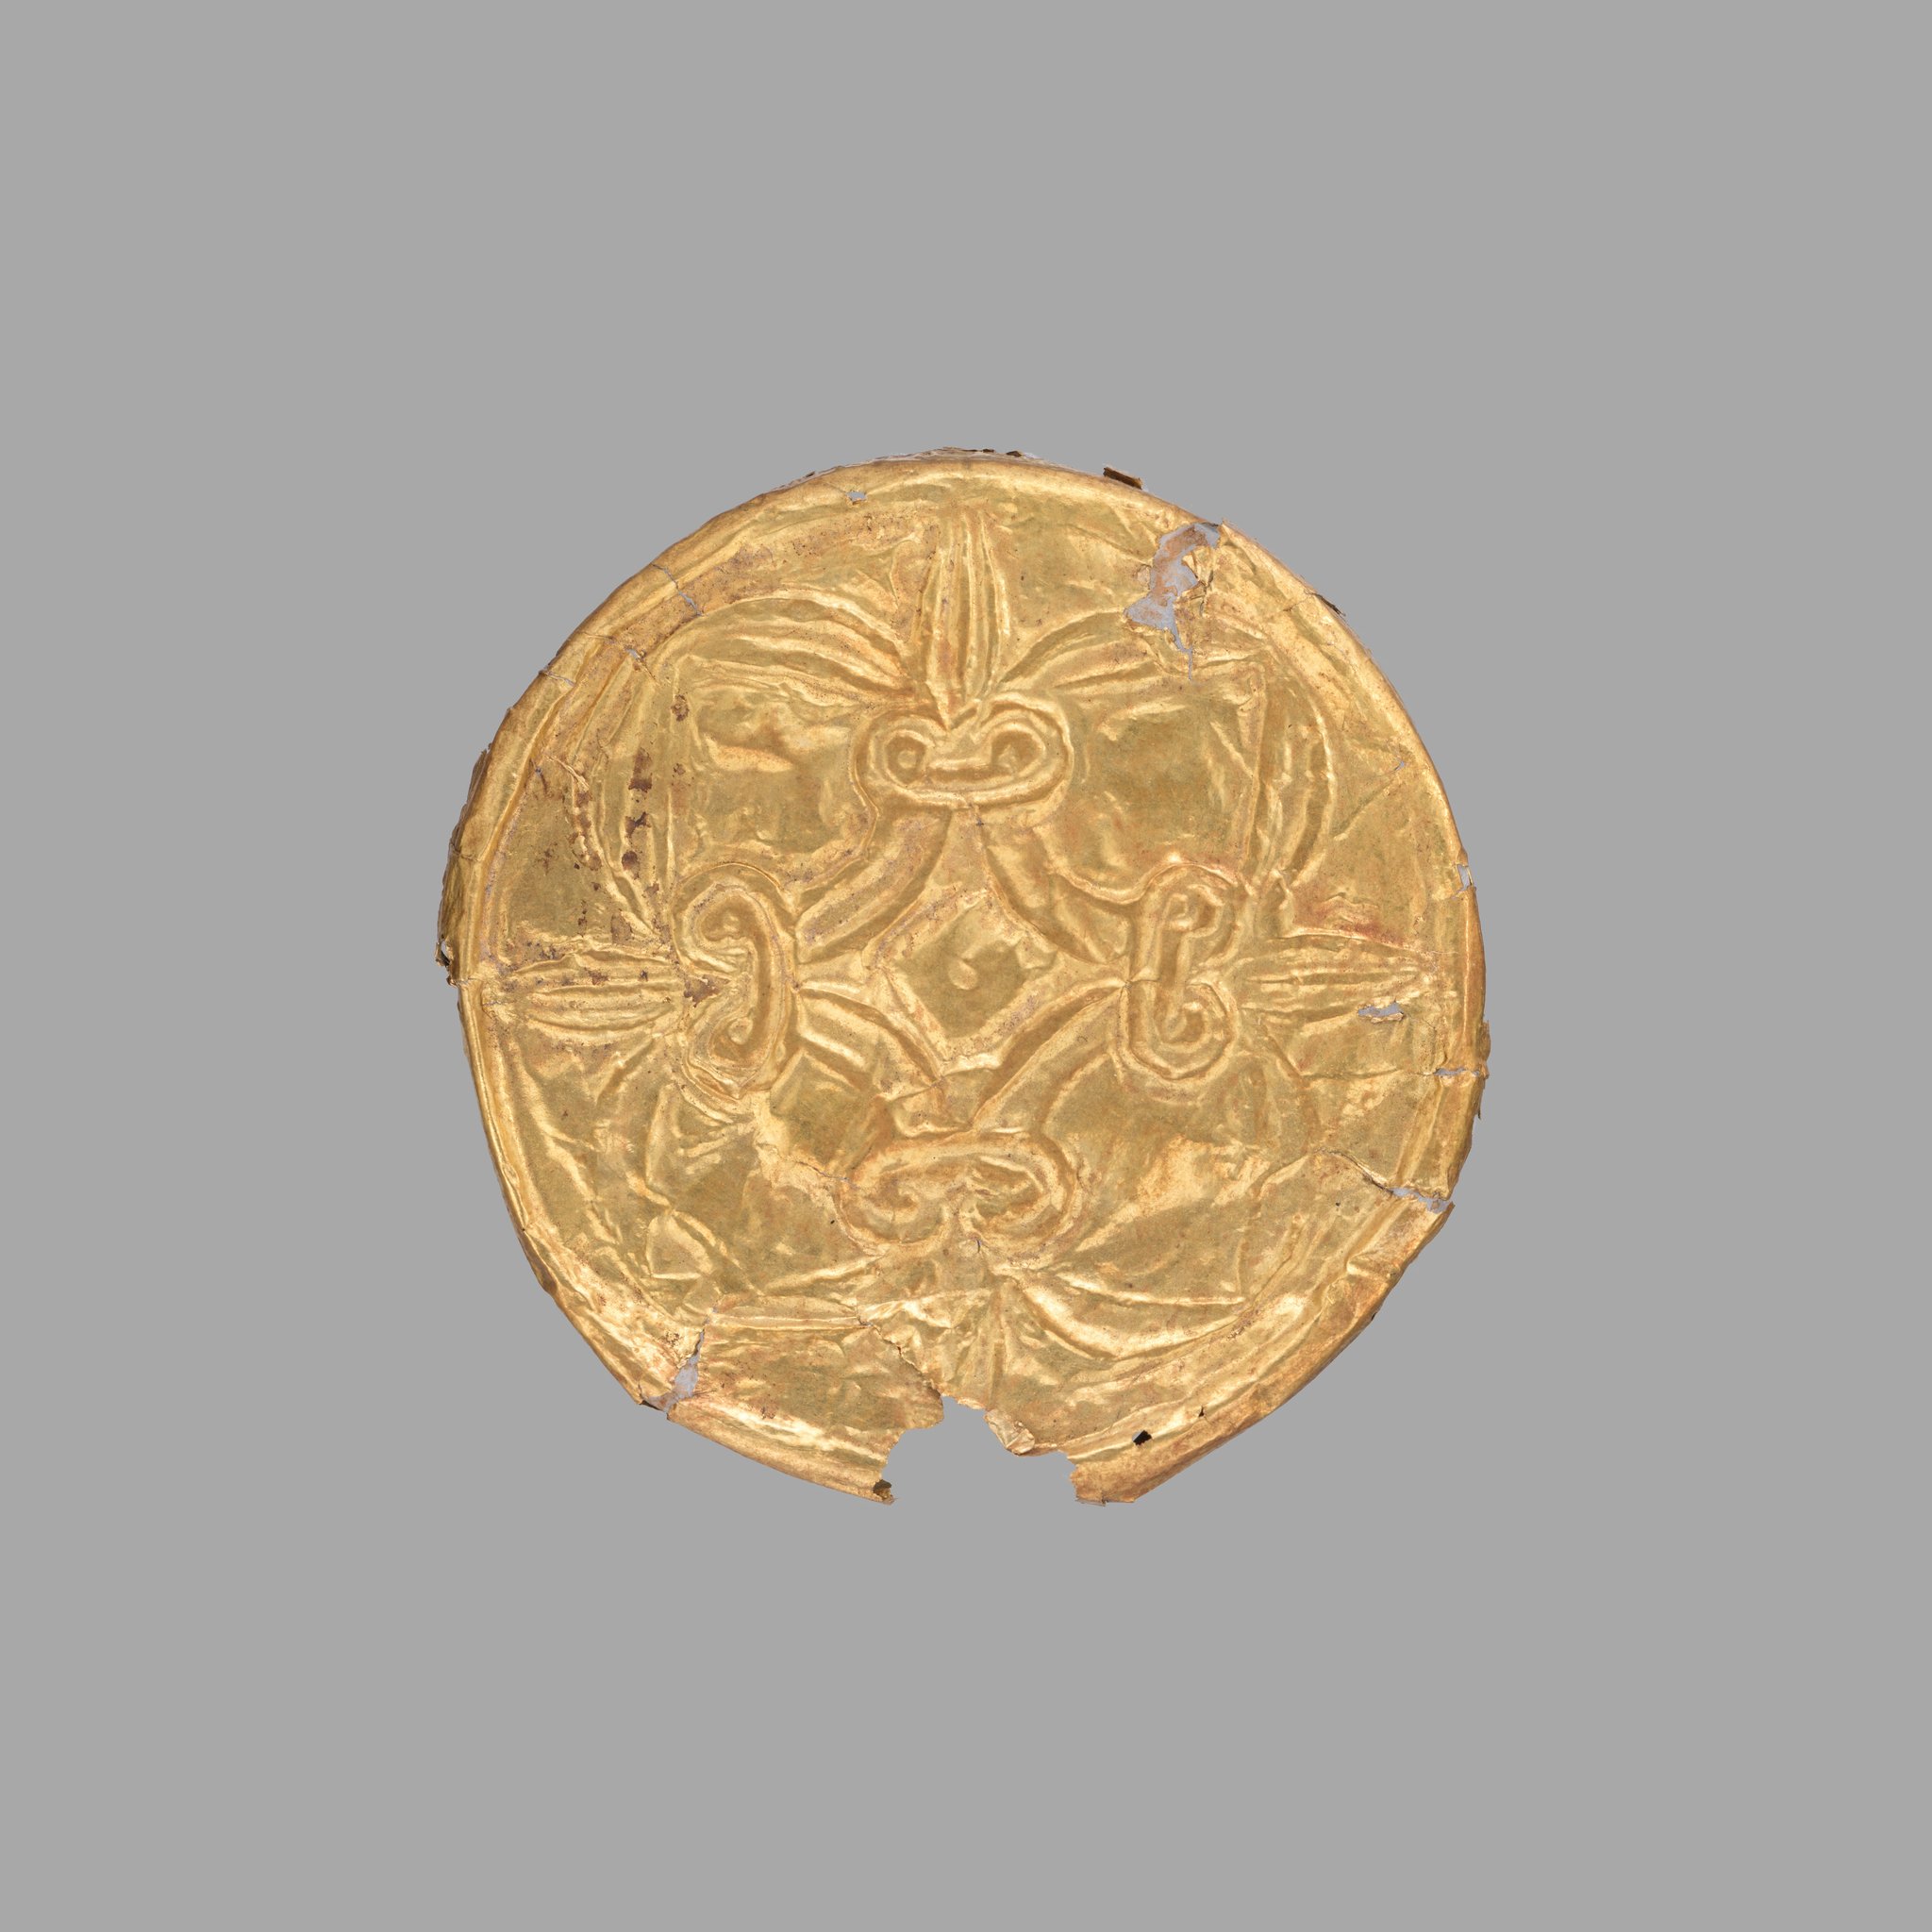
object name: roundel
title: Gold roundel with stamped designs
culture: cypriot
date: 1600-1050 BCE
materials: gold